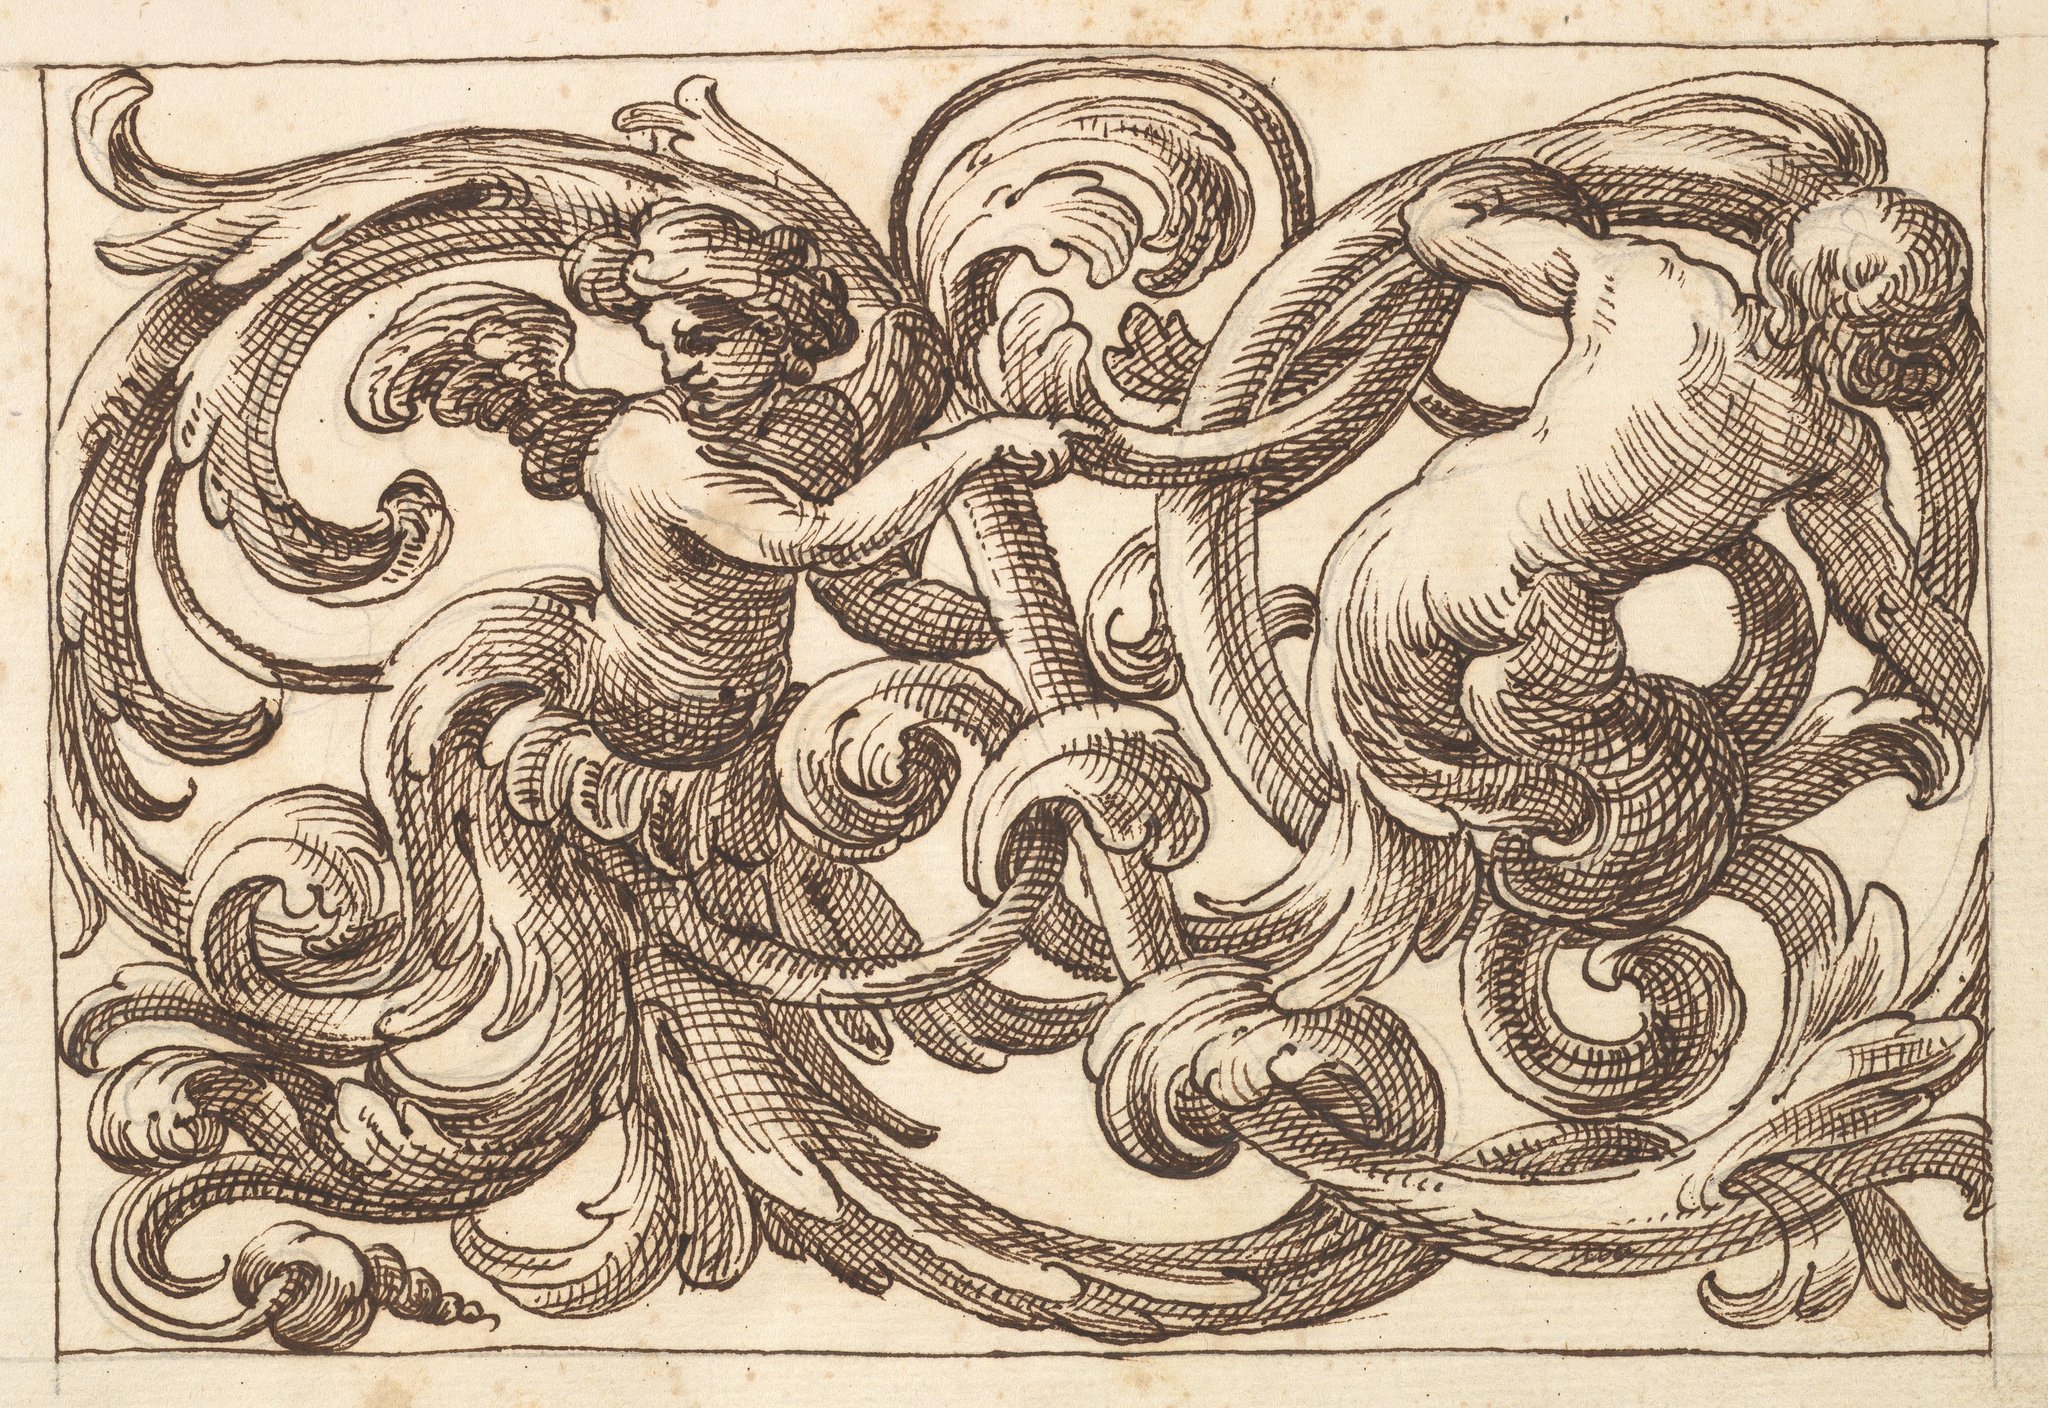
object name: collection ornament architecture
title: Horizontal Panel Design with Two Young Male Figures between Acanthus Rinceaux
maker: anonymous, italian, venetian, 17th century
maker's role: artist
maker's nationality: italian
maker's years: 1600-1700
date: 1601-1700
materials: ink, drawing material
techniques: pen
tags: men,acanthus